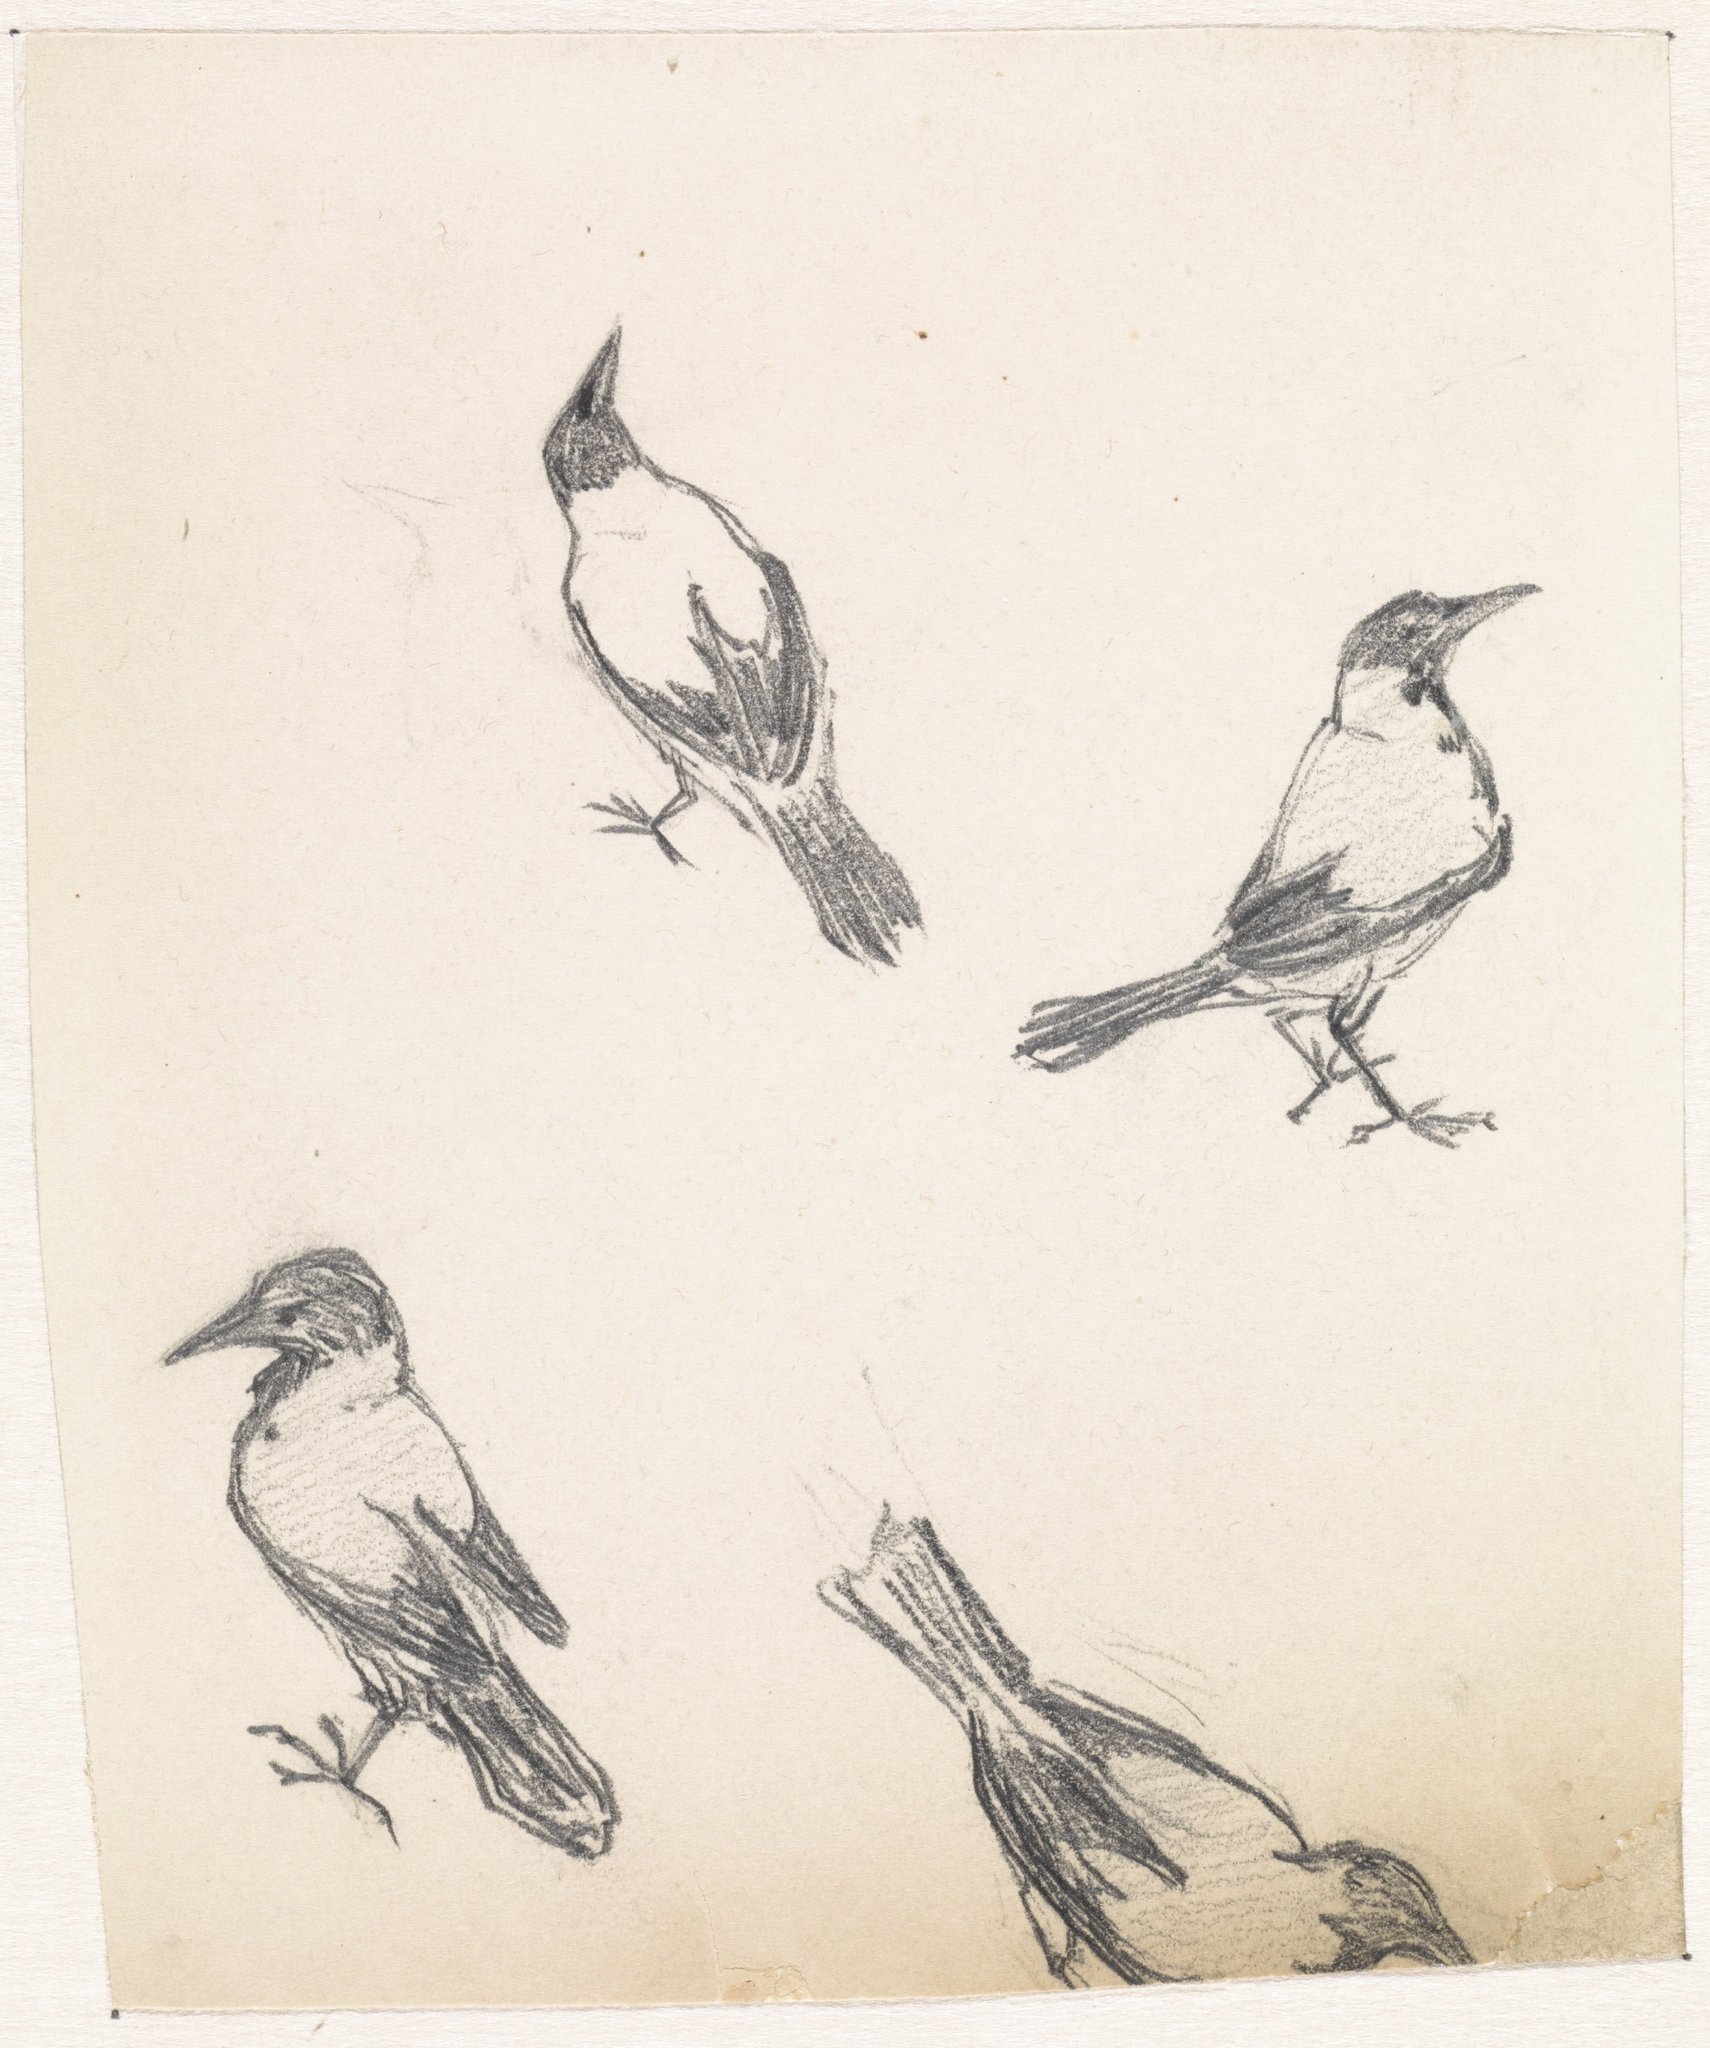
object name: drawing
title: Vier schetsen van een bonte kraai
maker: julie de graag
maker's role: draughtsman, print maker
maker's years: 1877-1924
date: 1887-1924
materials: paper, pencil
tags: song-birds: crow